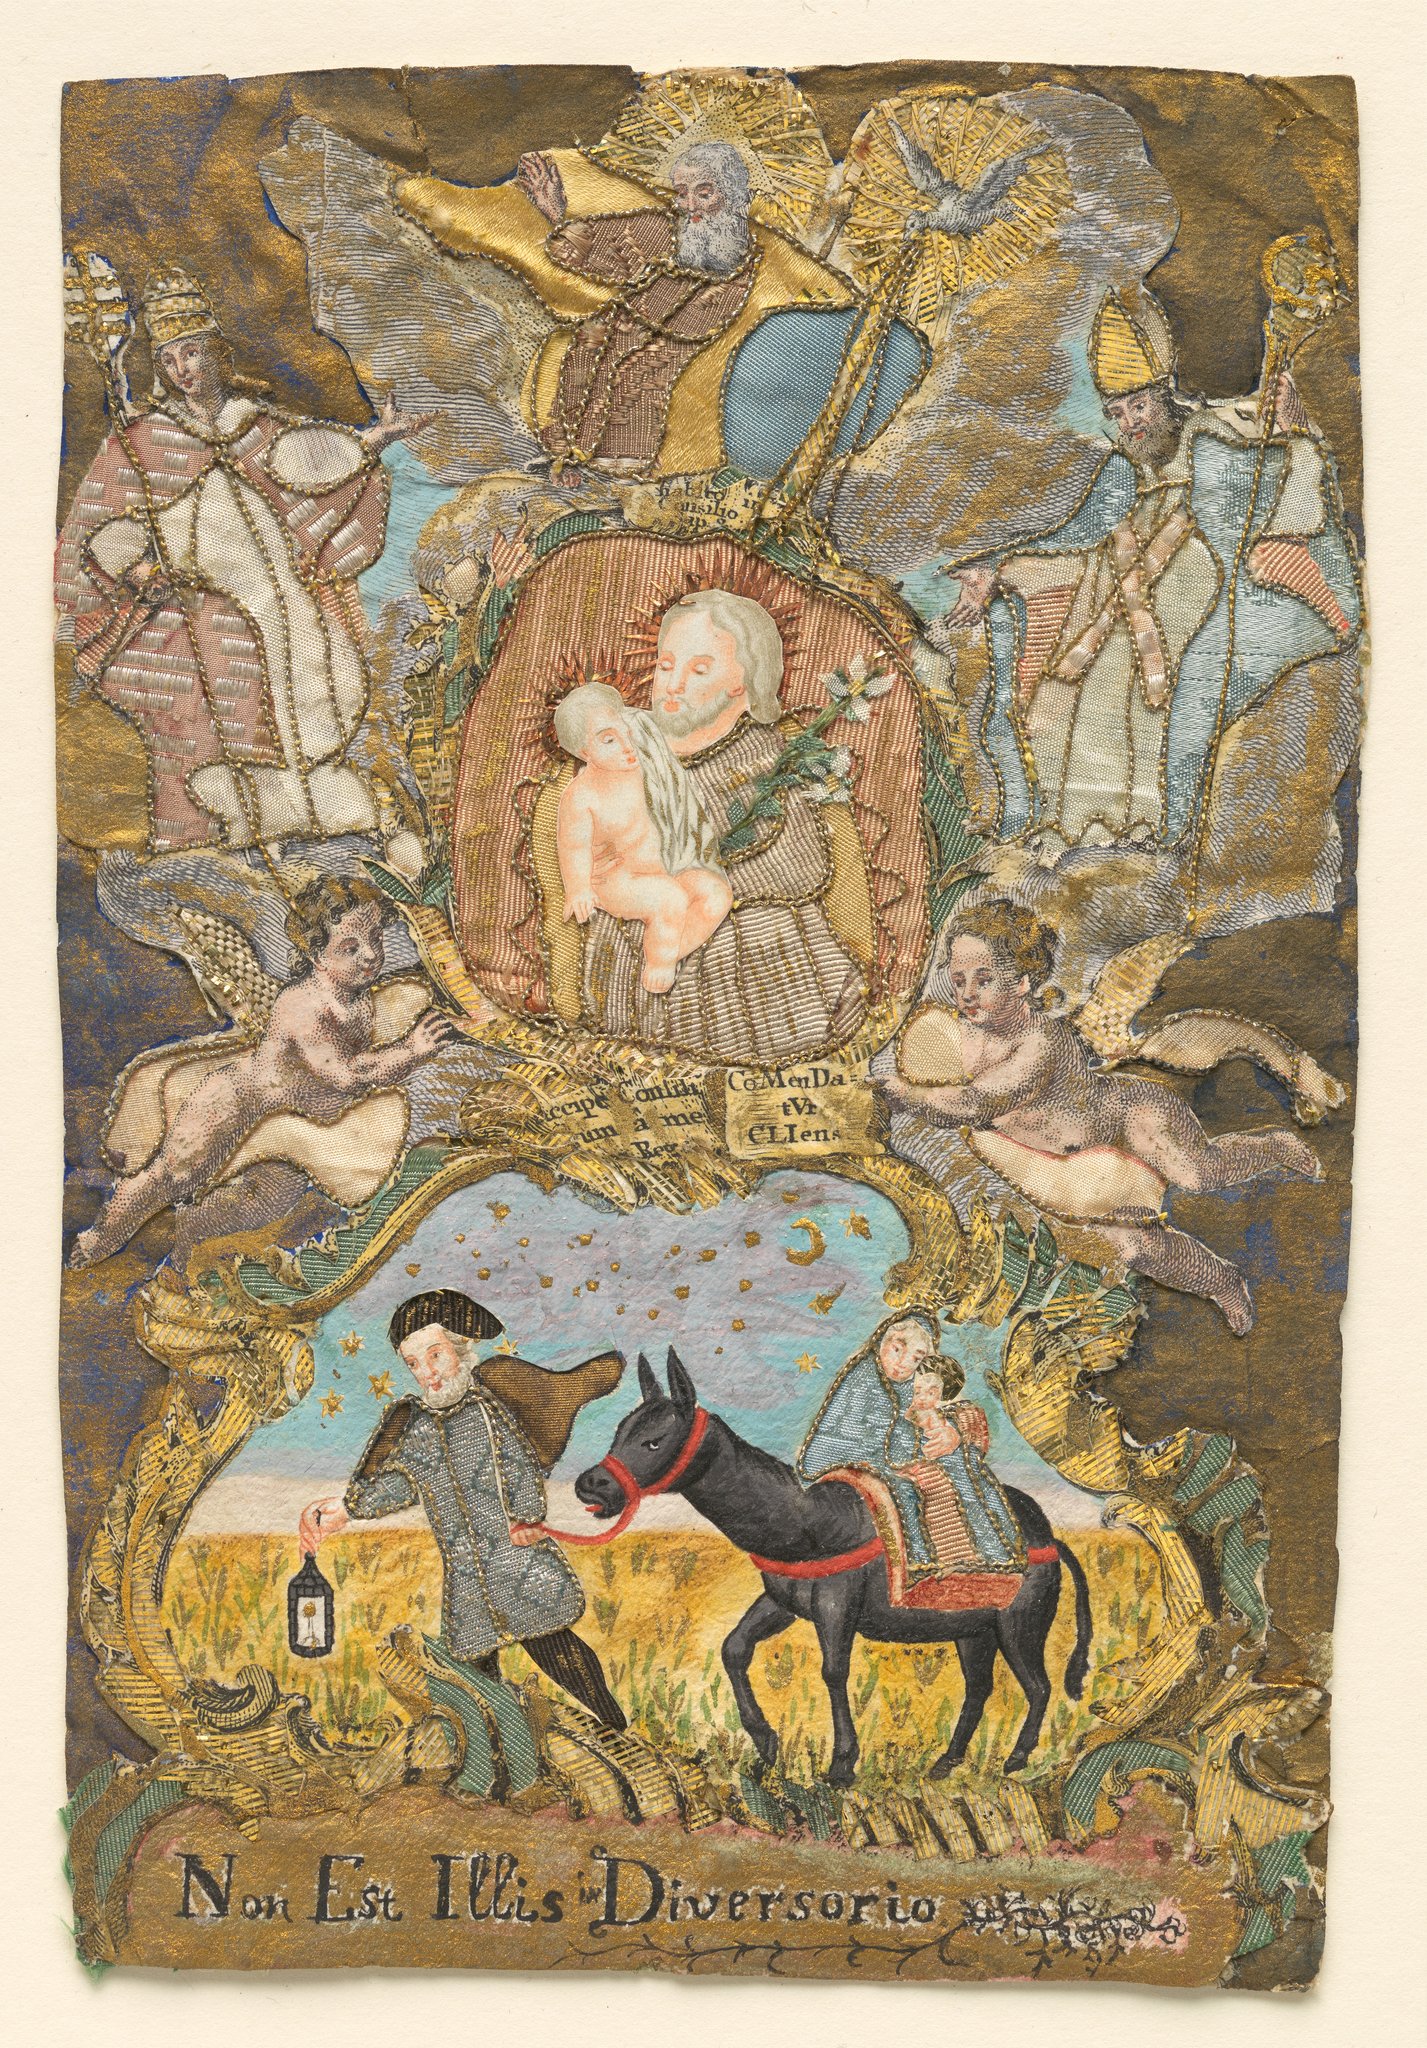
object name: cut paper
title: Saint Joseph with the Christ Child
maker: anonymous, german, 18th century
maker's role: artist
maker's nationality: german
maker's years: 1700-1800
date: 1701-1800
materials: metal thread, paint, paper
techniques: engraving, hand coloring